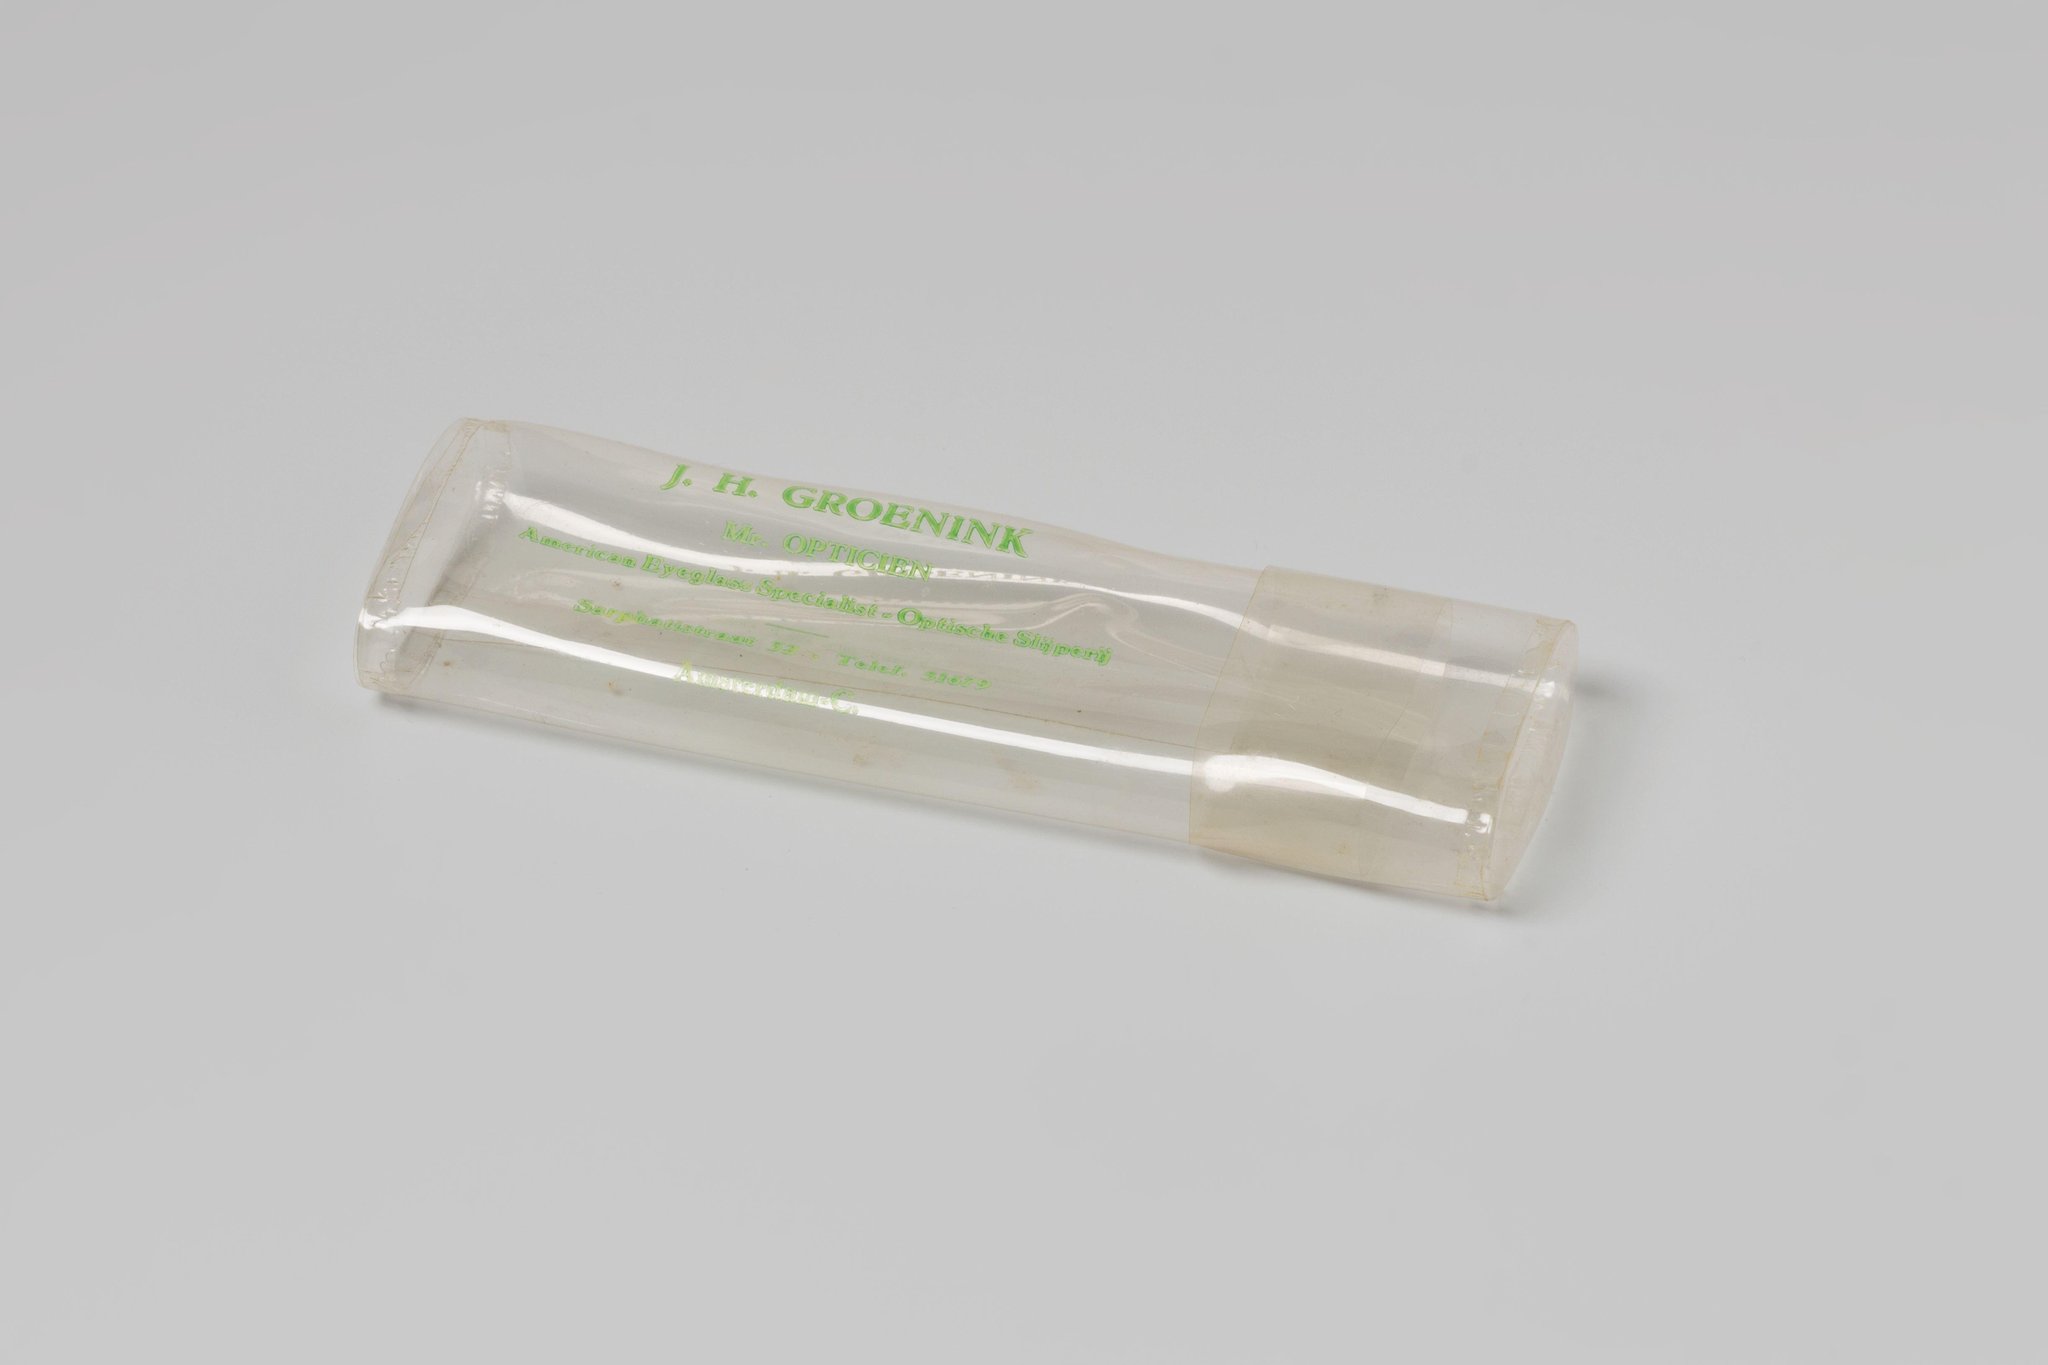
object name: brillendoos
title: Brillendoos van doorzichtige materiaal met de opdruk 'J.H. GROENINK Mr. Opticien Optische slijperij Sarphatistraat 52 / Tel. 51079 / Amsterdam C'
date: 1920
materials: ink, plastic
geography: amsterdam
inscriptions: address: ‘J.H. GROENINK Mr. Opticien Optische slijperij Sarphatistraat 52 / Tel. 51079 / Amsterdam C'’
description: Face à main met ronde glazen en van verguld koper met wit en donkerblauw email. In doorzichtig doosje met aders: Art déco of ned-renaissance. Model: Handvat in de vorm van een lepelsteel, waaronderaan een vast en een los oogje voor een ketting Bovenaan smalleronde ringen om de glazen heen, die een geslepen ronde facet hebben voor het dichtbij zien Ronde neusboog met scharnieren, zodat de twee glazen teramen gevouwen kunnen worden. Een springveer is in de steel weggewerkt en wordt met een klein knopje onderaan in werking gesteld. Versiering: In het slanke deel van de steel loopt een wit omrande gerekte druppel in goud. In het verbrede eind lopen om het wit twee symmetrische gouden bladeren op donkerblauwe grond. Binnen de witte rand is een geraveerde goudne druppel. De neusboog is en reliëf geciseleerd. Adres op het doosje. J. H. Groenink Mr. Opticien Optrische slijperij Sarphatistraat 52/ Tel. 51079/ Amsterdam C. Toestand: Van het linkerglas is een scherfje af. Een ketting ontbreekt.